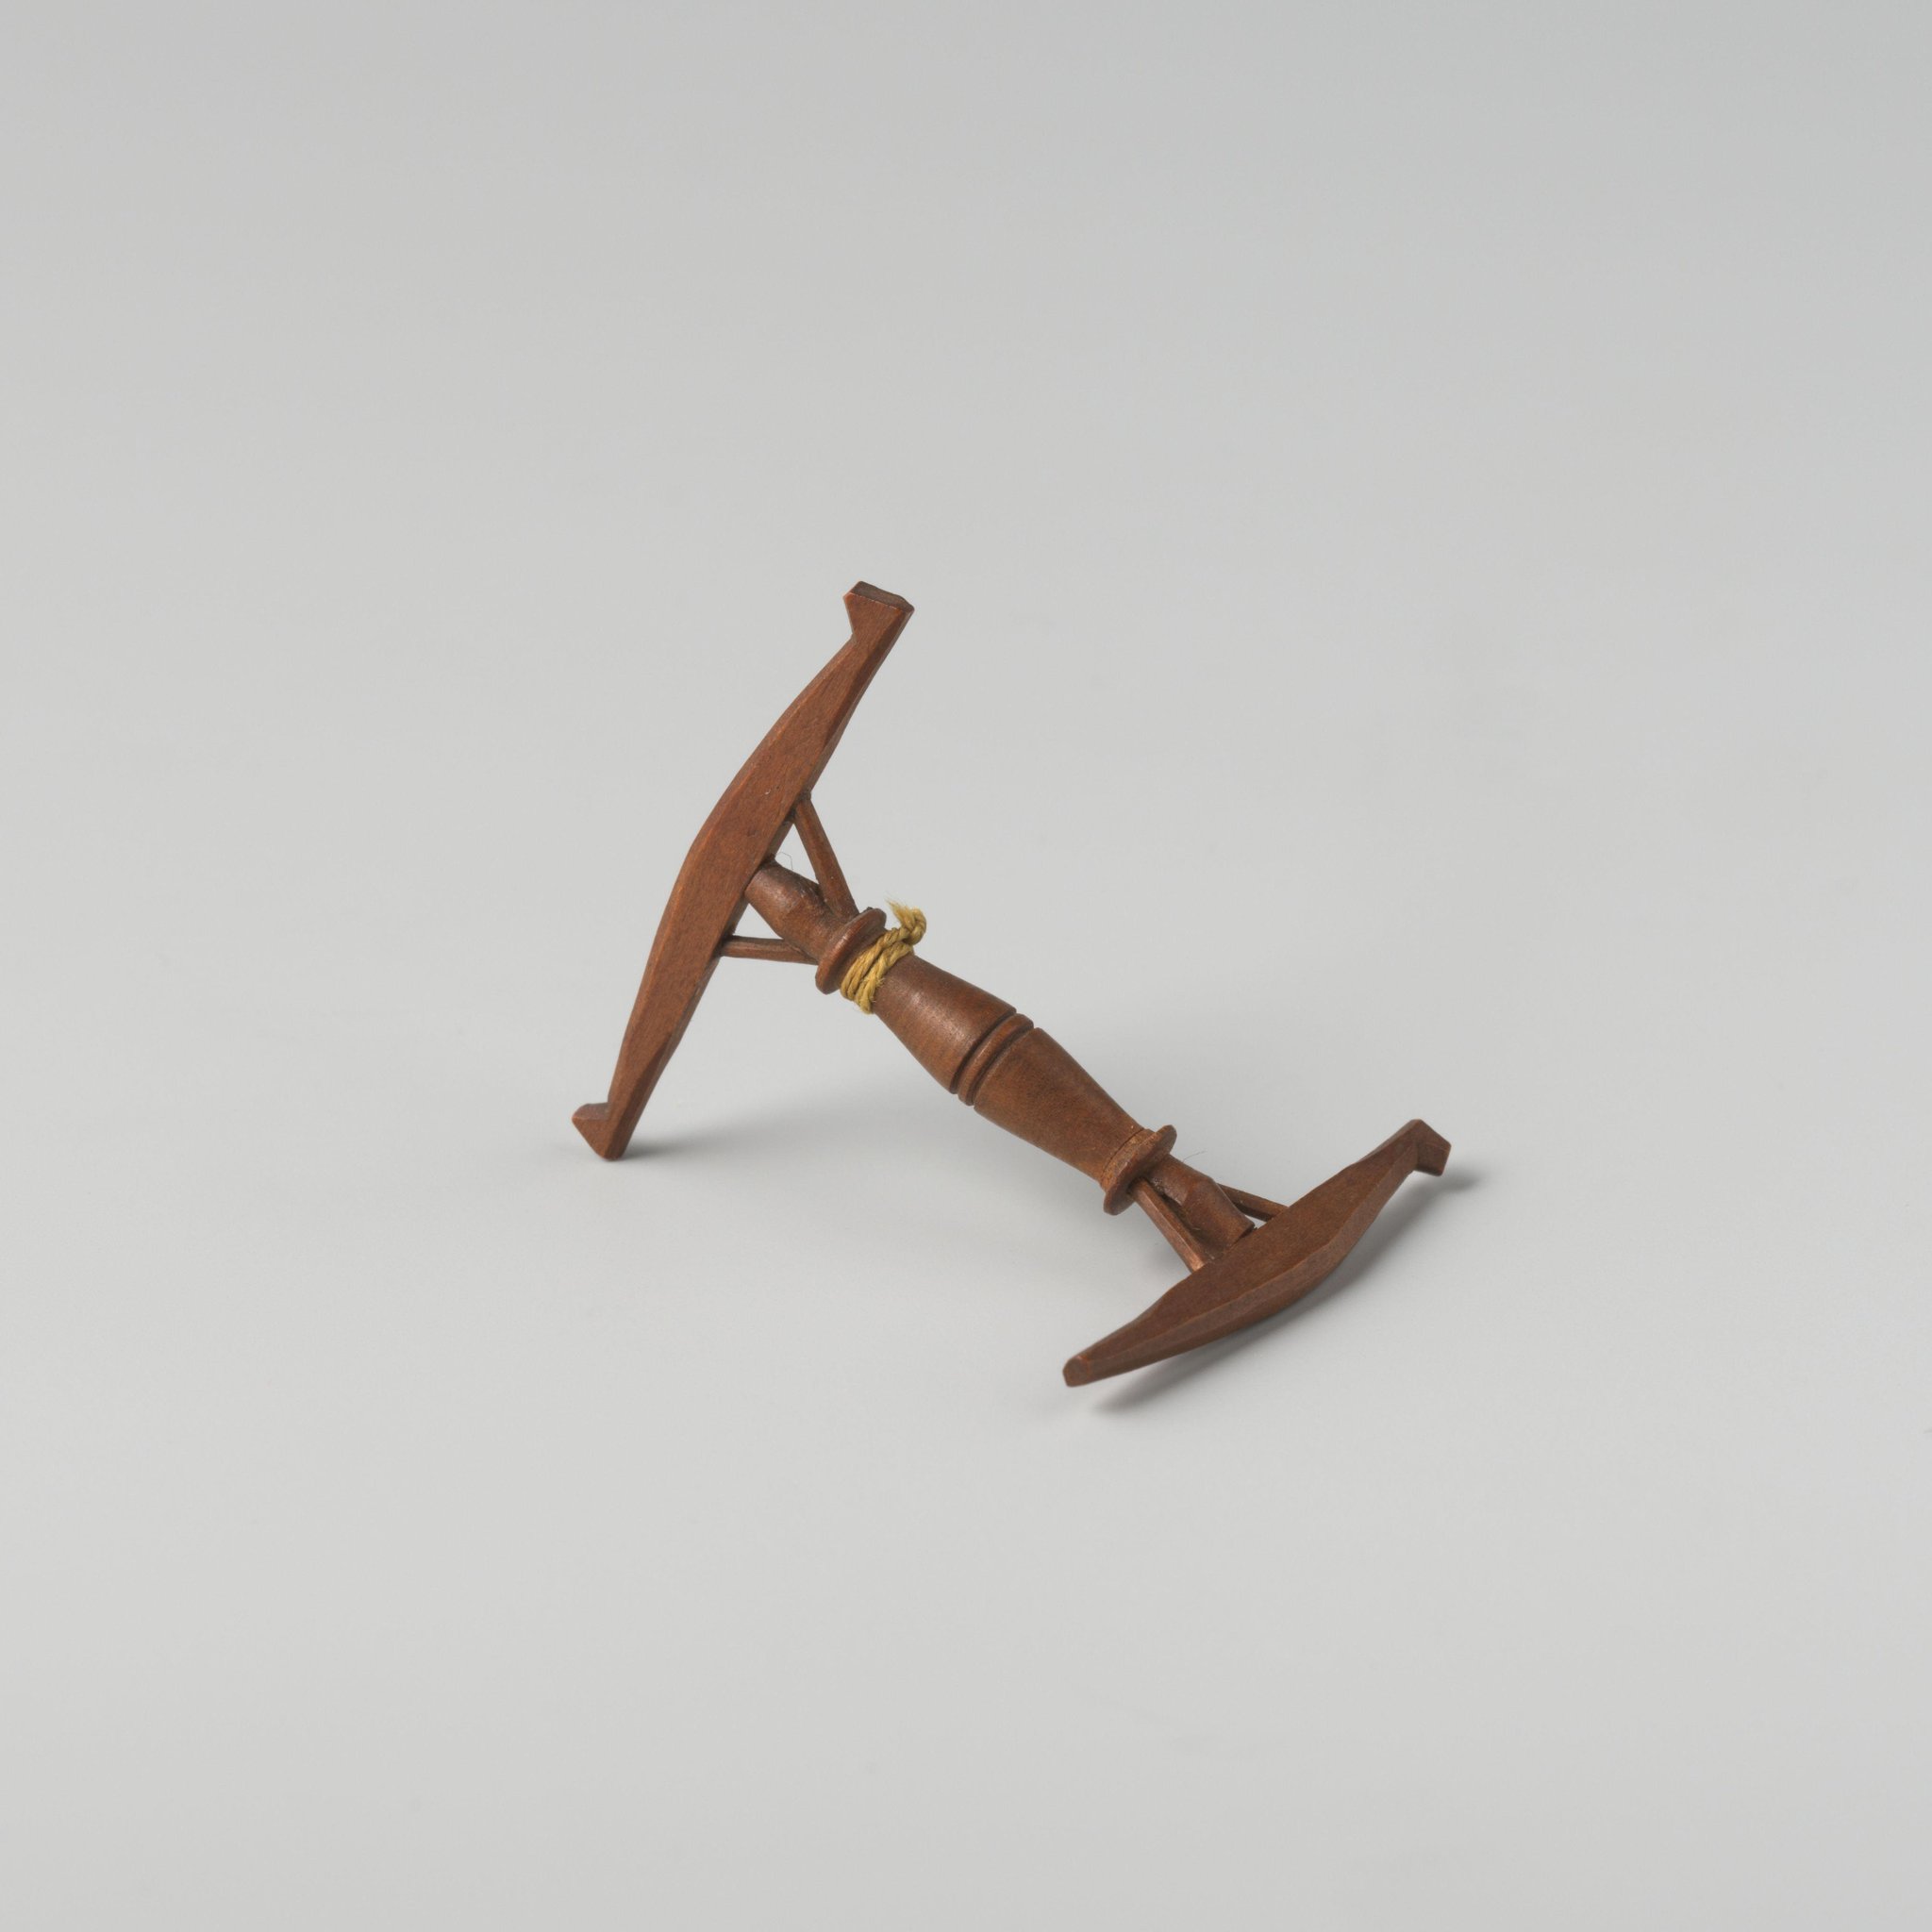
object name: haspel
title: Haspel met gedraaide verbindingsspijl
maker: Anonymous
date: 1690-1710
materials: wood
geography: amsterdam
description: Haspel, vervaardigd van esdoornhout, gedetailleerd uitgevoerd met gedraaide verbindingsspijl en door kleine stijltjes ondersteunde dwarssporten, die aan drie van de vier uiteinden een opgaande haak hebben (om het afglijden van de draad te voorkomen).